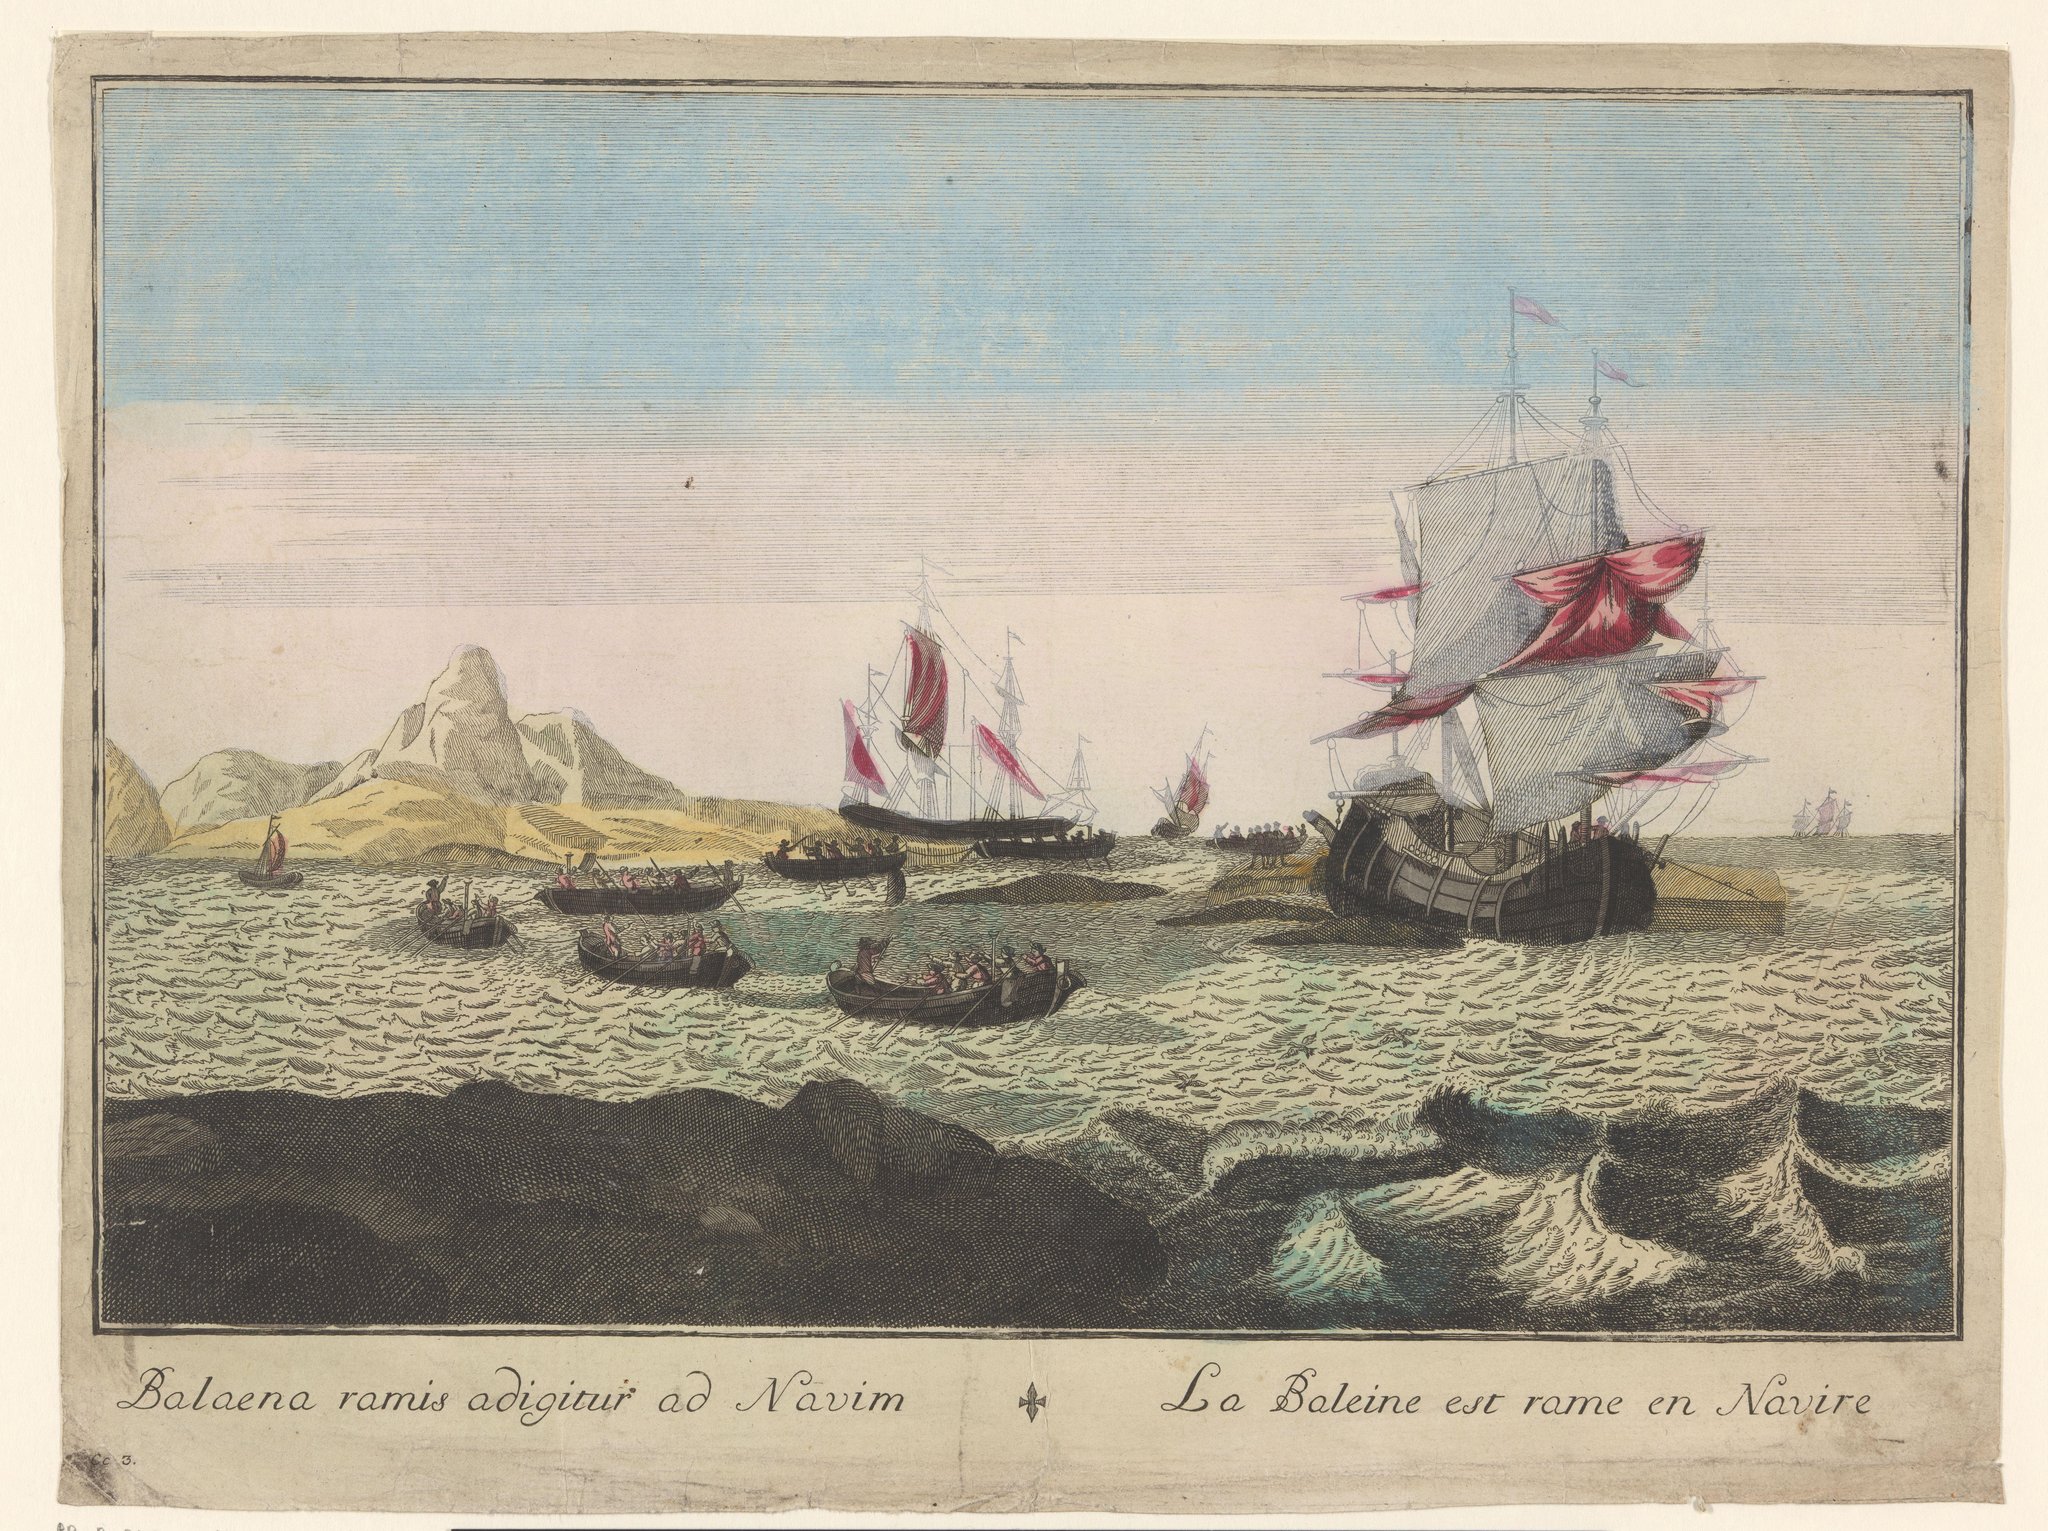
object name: print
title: Balaena ramis adigitur ad Navim / La Baleine est rame en Navire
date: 1700-1799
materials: paper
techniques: etching, hand coloring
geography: france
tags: whale fishery, whaling, swimming mammals: whale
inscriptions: collector's mark: Lugt 2228